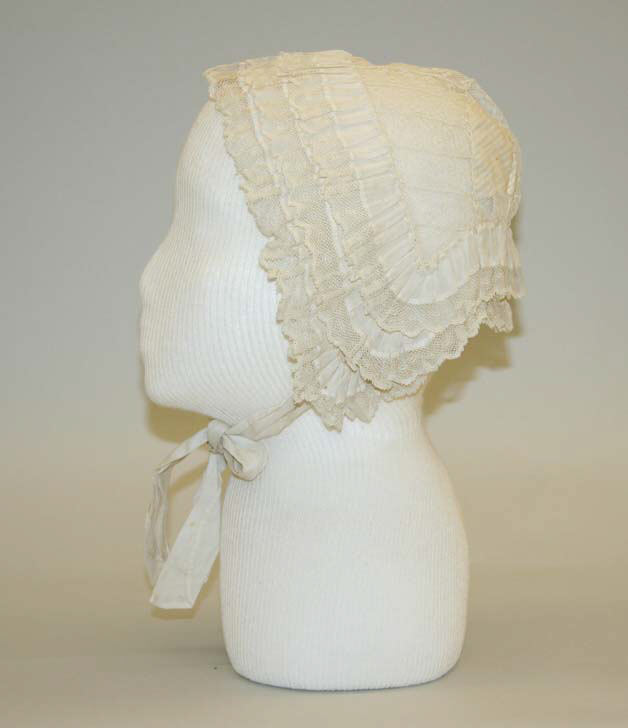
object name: cap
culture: american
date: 1850-1869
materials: cotton, linen